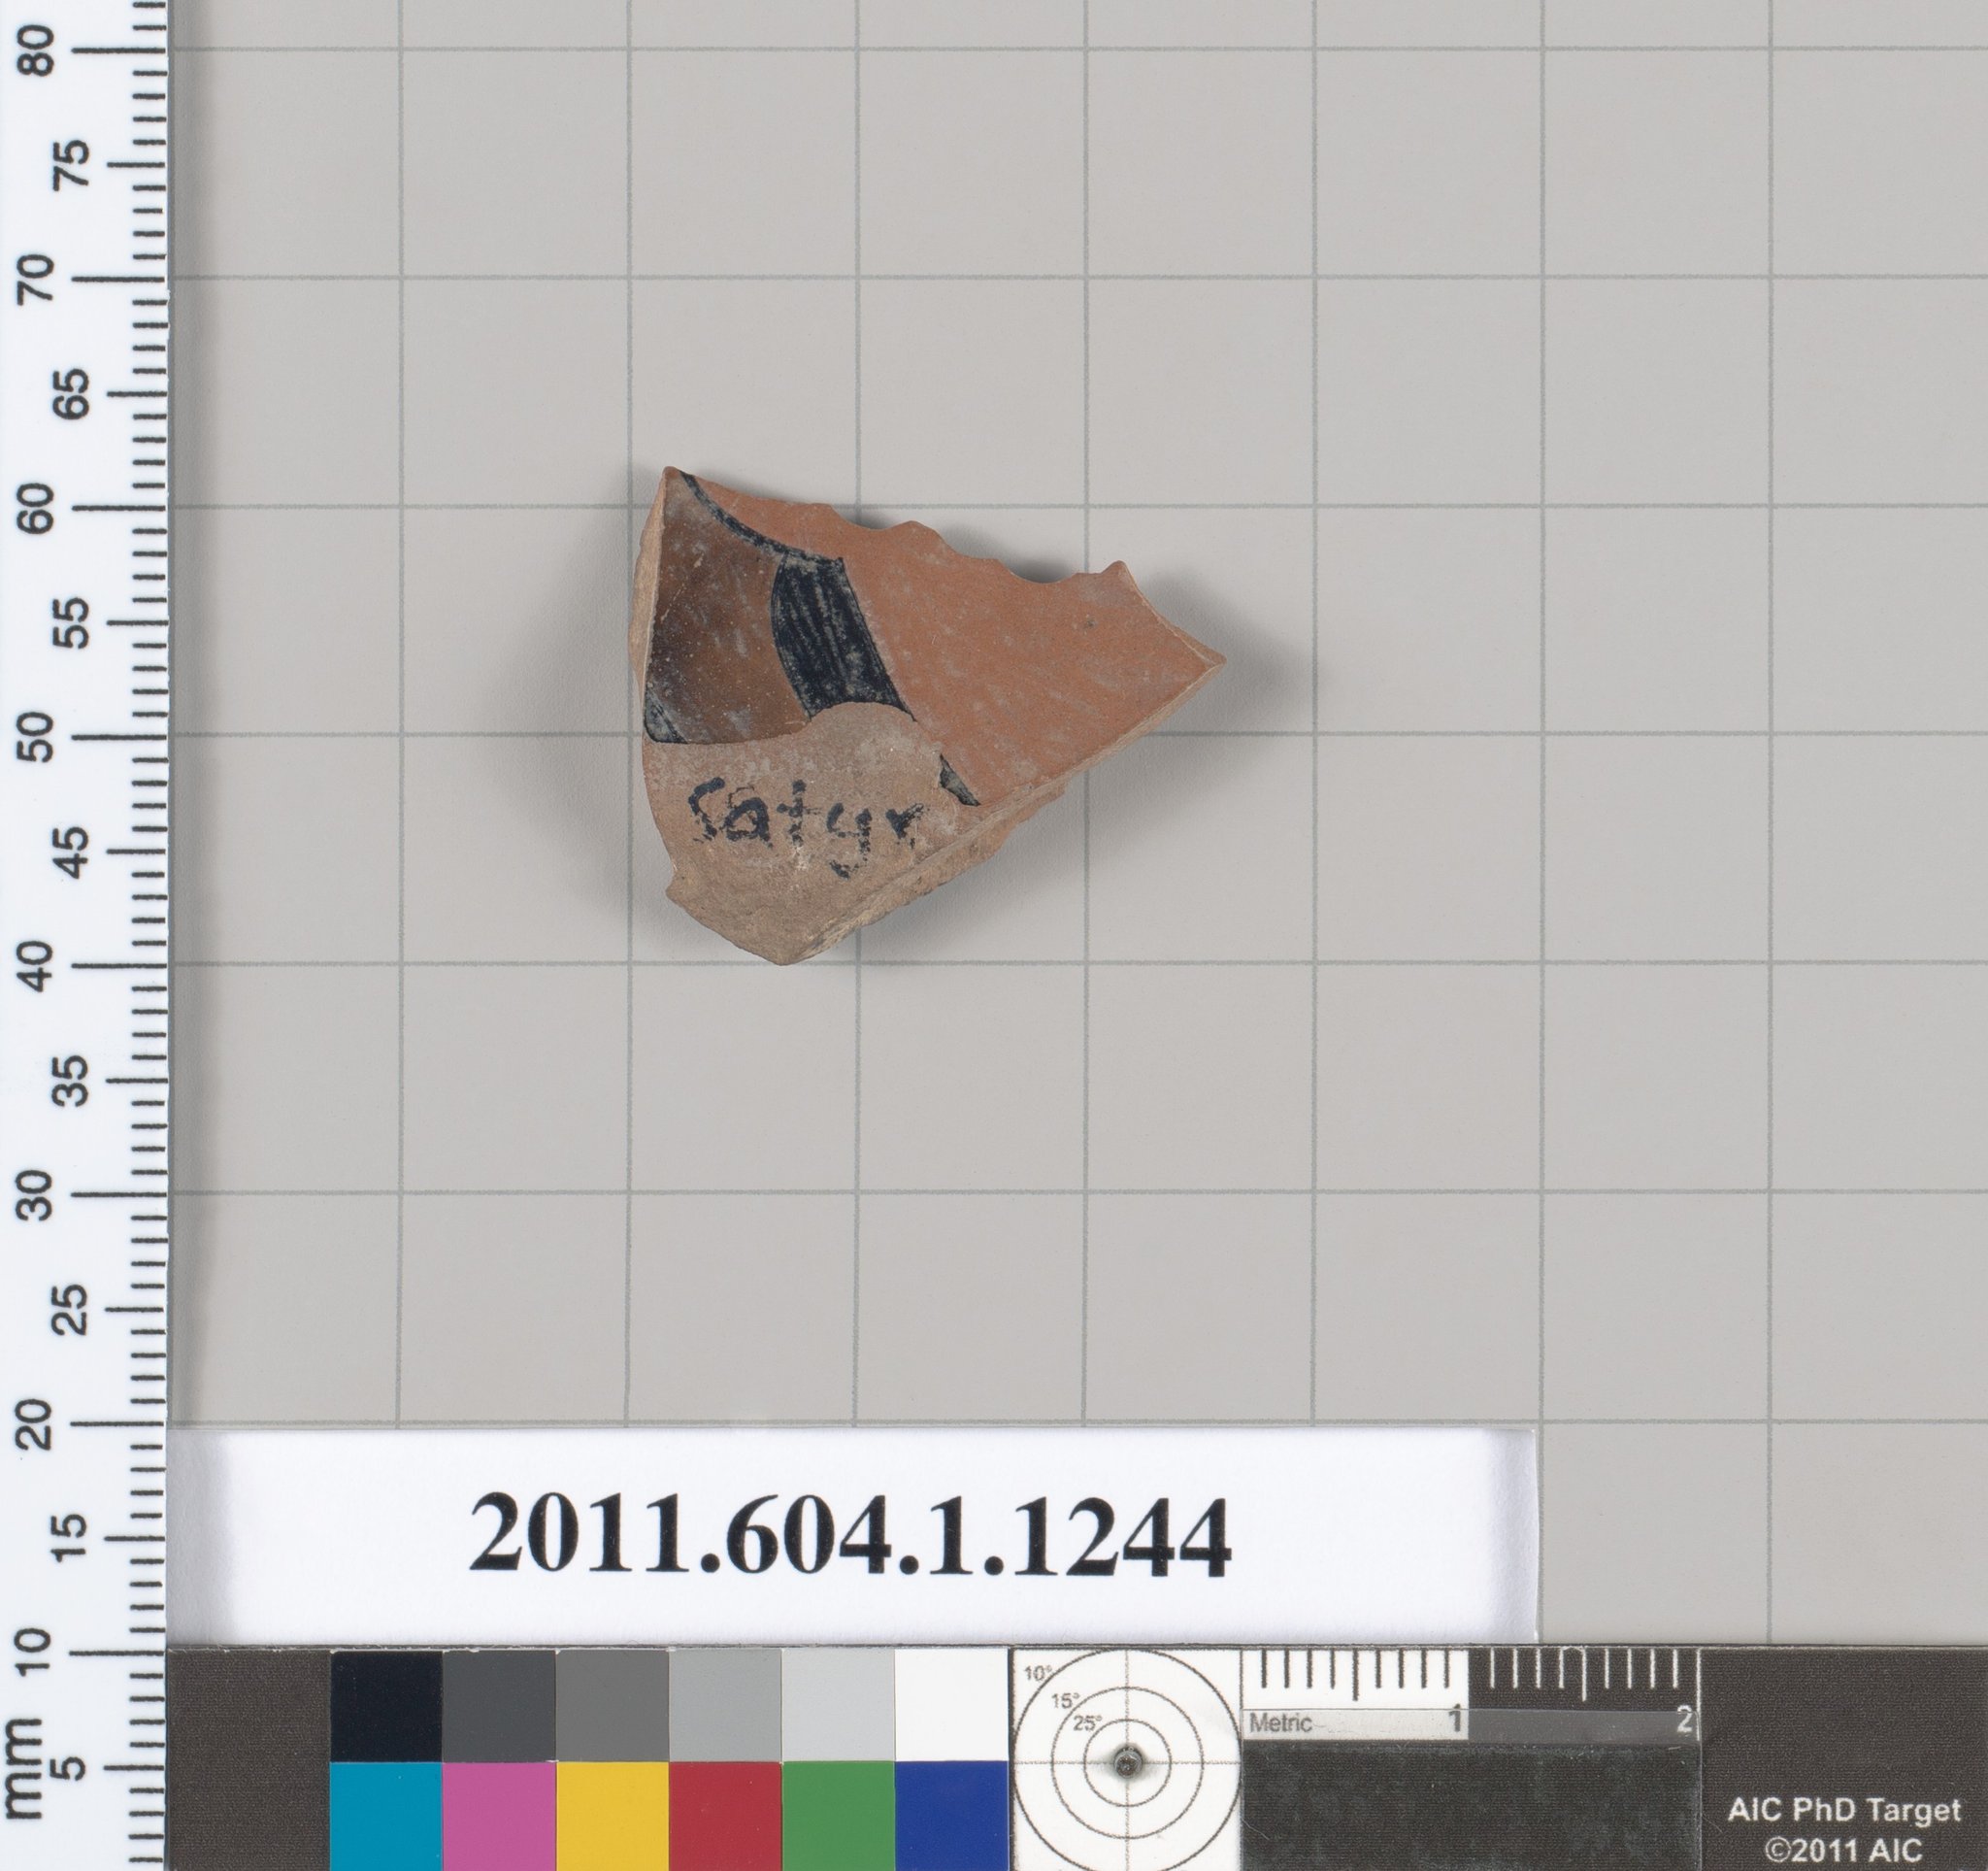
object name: kylix fragment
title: Terracotta fragment of a kylix (drinking cup)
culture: greek, attic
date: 500-401 BCE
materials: terracotta